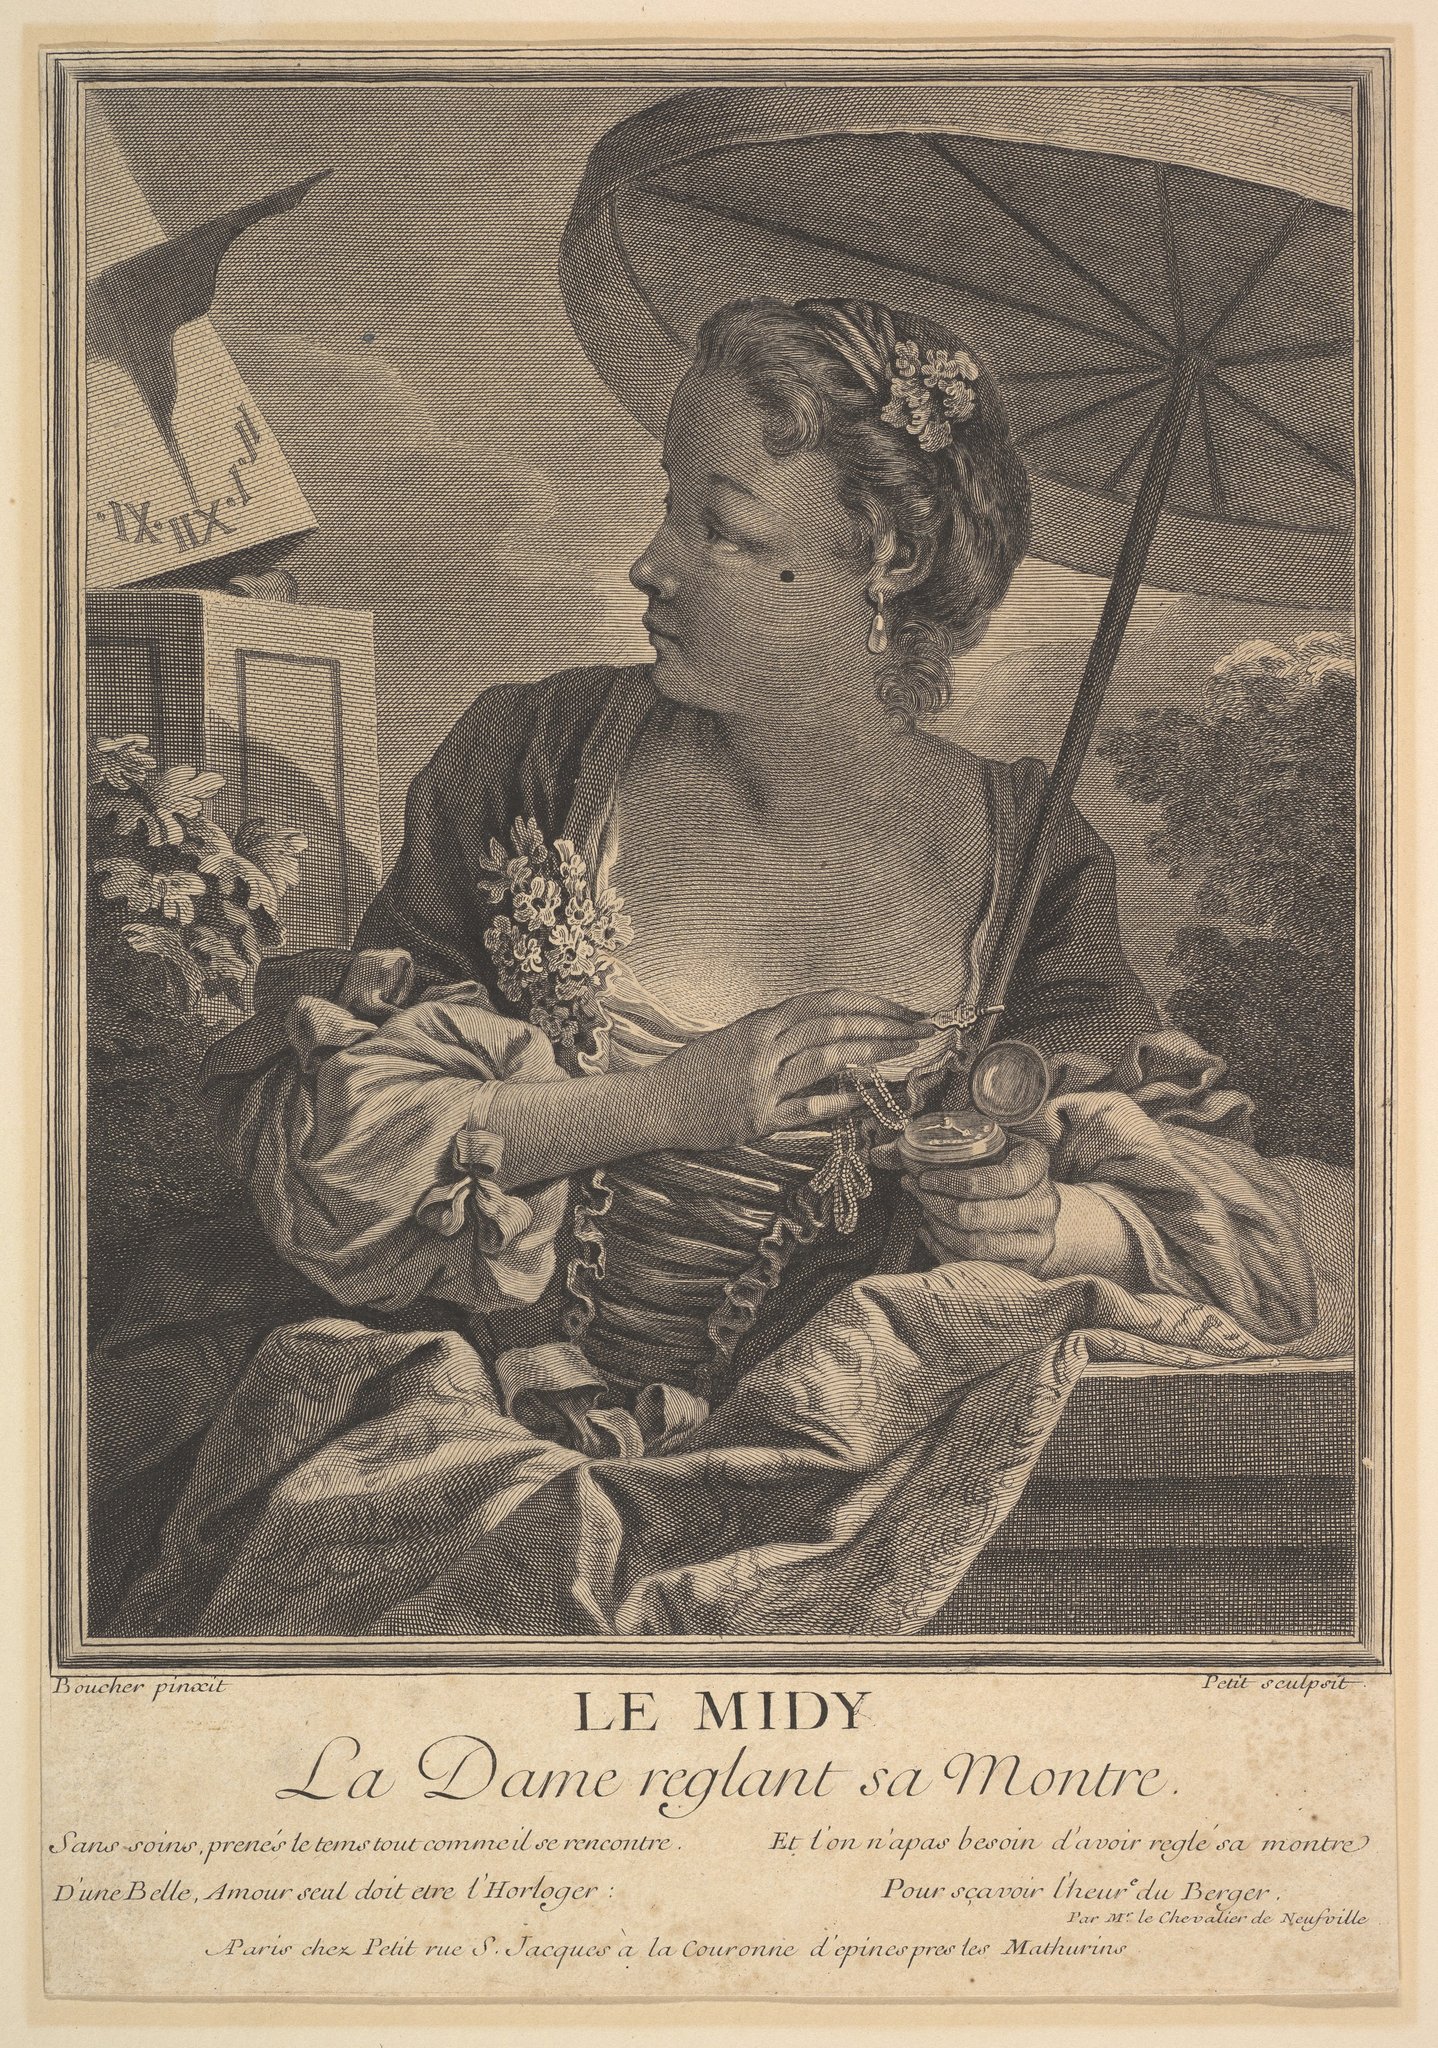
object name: print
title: Midday. A Lady Setting Her Watch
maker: gilles edme petit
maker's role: artist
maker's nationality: french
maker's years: 1694-1760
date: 1694-1760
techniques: engraving, etching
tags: pocket watches,women,parasols